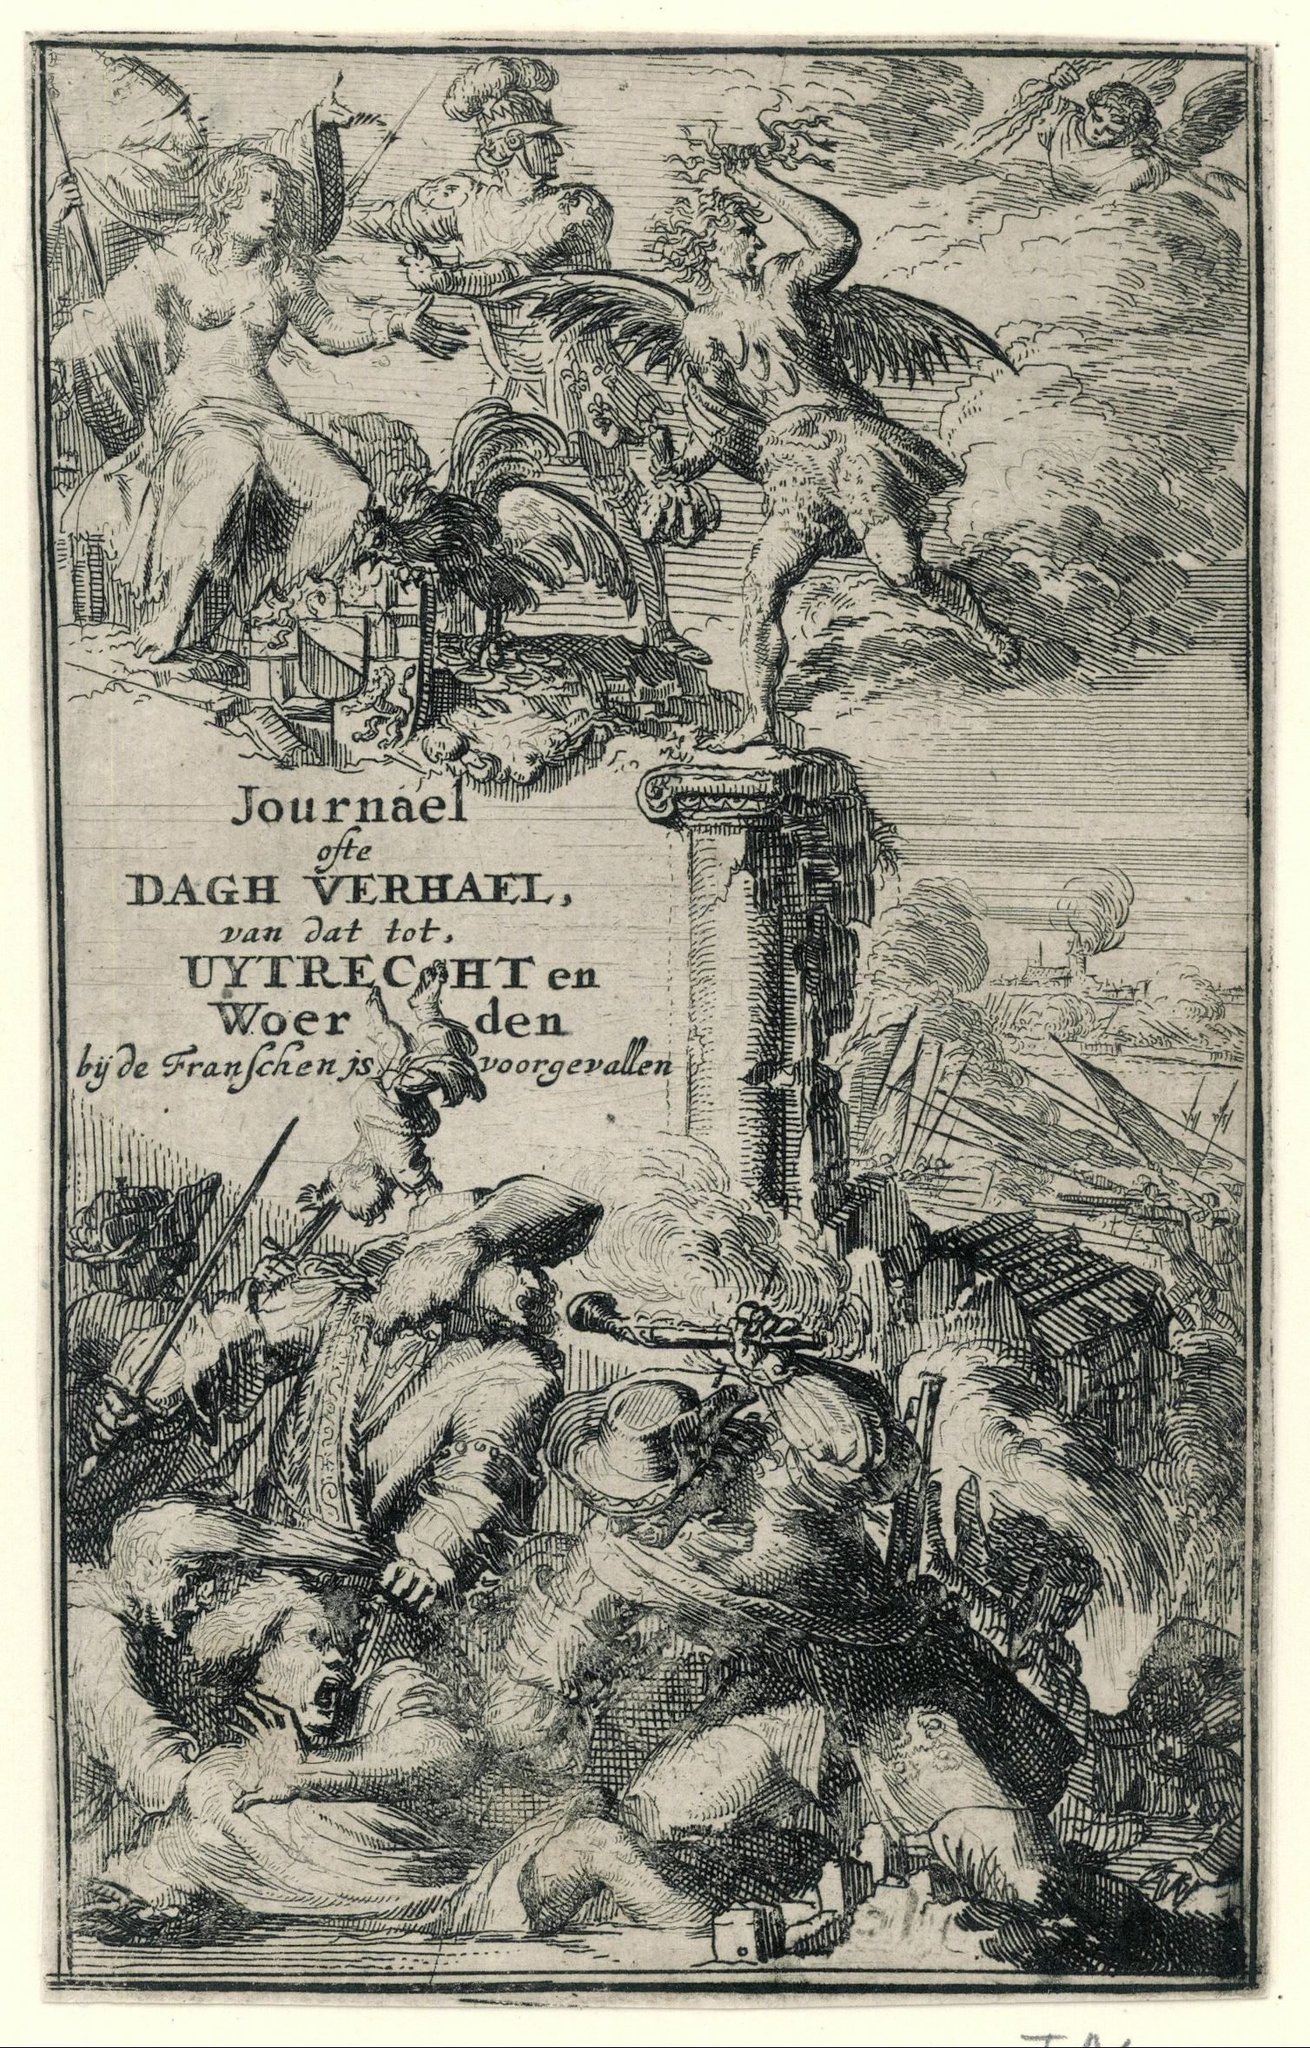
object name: print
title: Titelprent voor: Journael, of dagelijcksch Verhael van de handel der Franschen in de Steden van Uytrecht en Woerden, serdert hun koomst daer binnen, tot aan hun Vertrek, 1674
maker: romeyn de hooghe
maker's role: draughtsman, goldsmith, painter, print maker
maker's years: 1645-1708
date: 1672-1674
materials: paper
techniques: etching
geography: northern netherlands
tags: massacre ~ war, utrecht, rampjaar (disaster year)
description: Titelprent voor het boek: Journael, of dagelijcksch Verhael van de handel der Franschen in de Steden van Uytrecht en Woerden, serdert hun koomst daer binnen, tot aan hun Vertrek, 1674. In de onderste deel van de voorstelling terroriseren Franse soldaten de bevolking. Hierboven een allegorische voorstelling met de Nederlandse Maagd die belaagd wordt door de paus, Franse Oorlogszucht en een gevleugelde monsterlijke personificatie van Afgust en Tirannie.